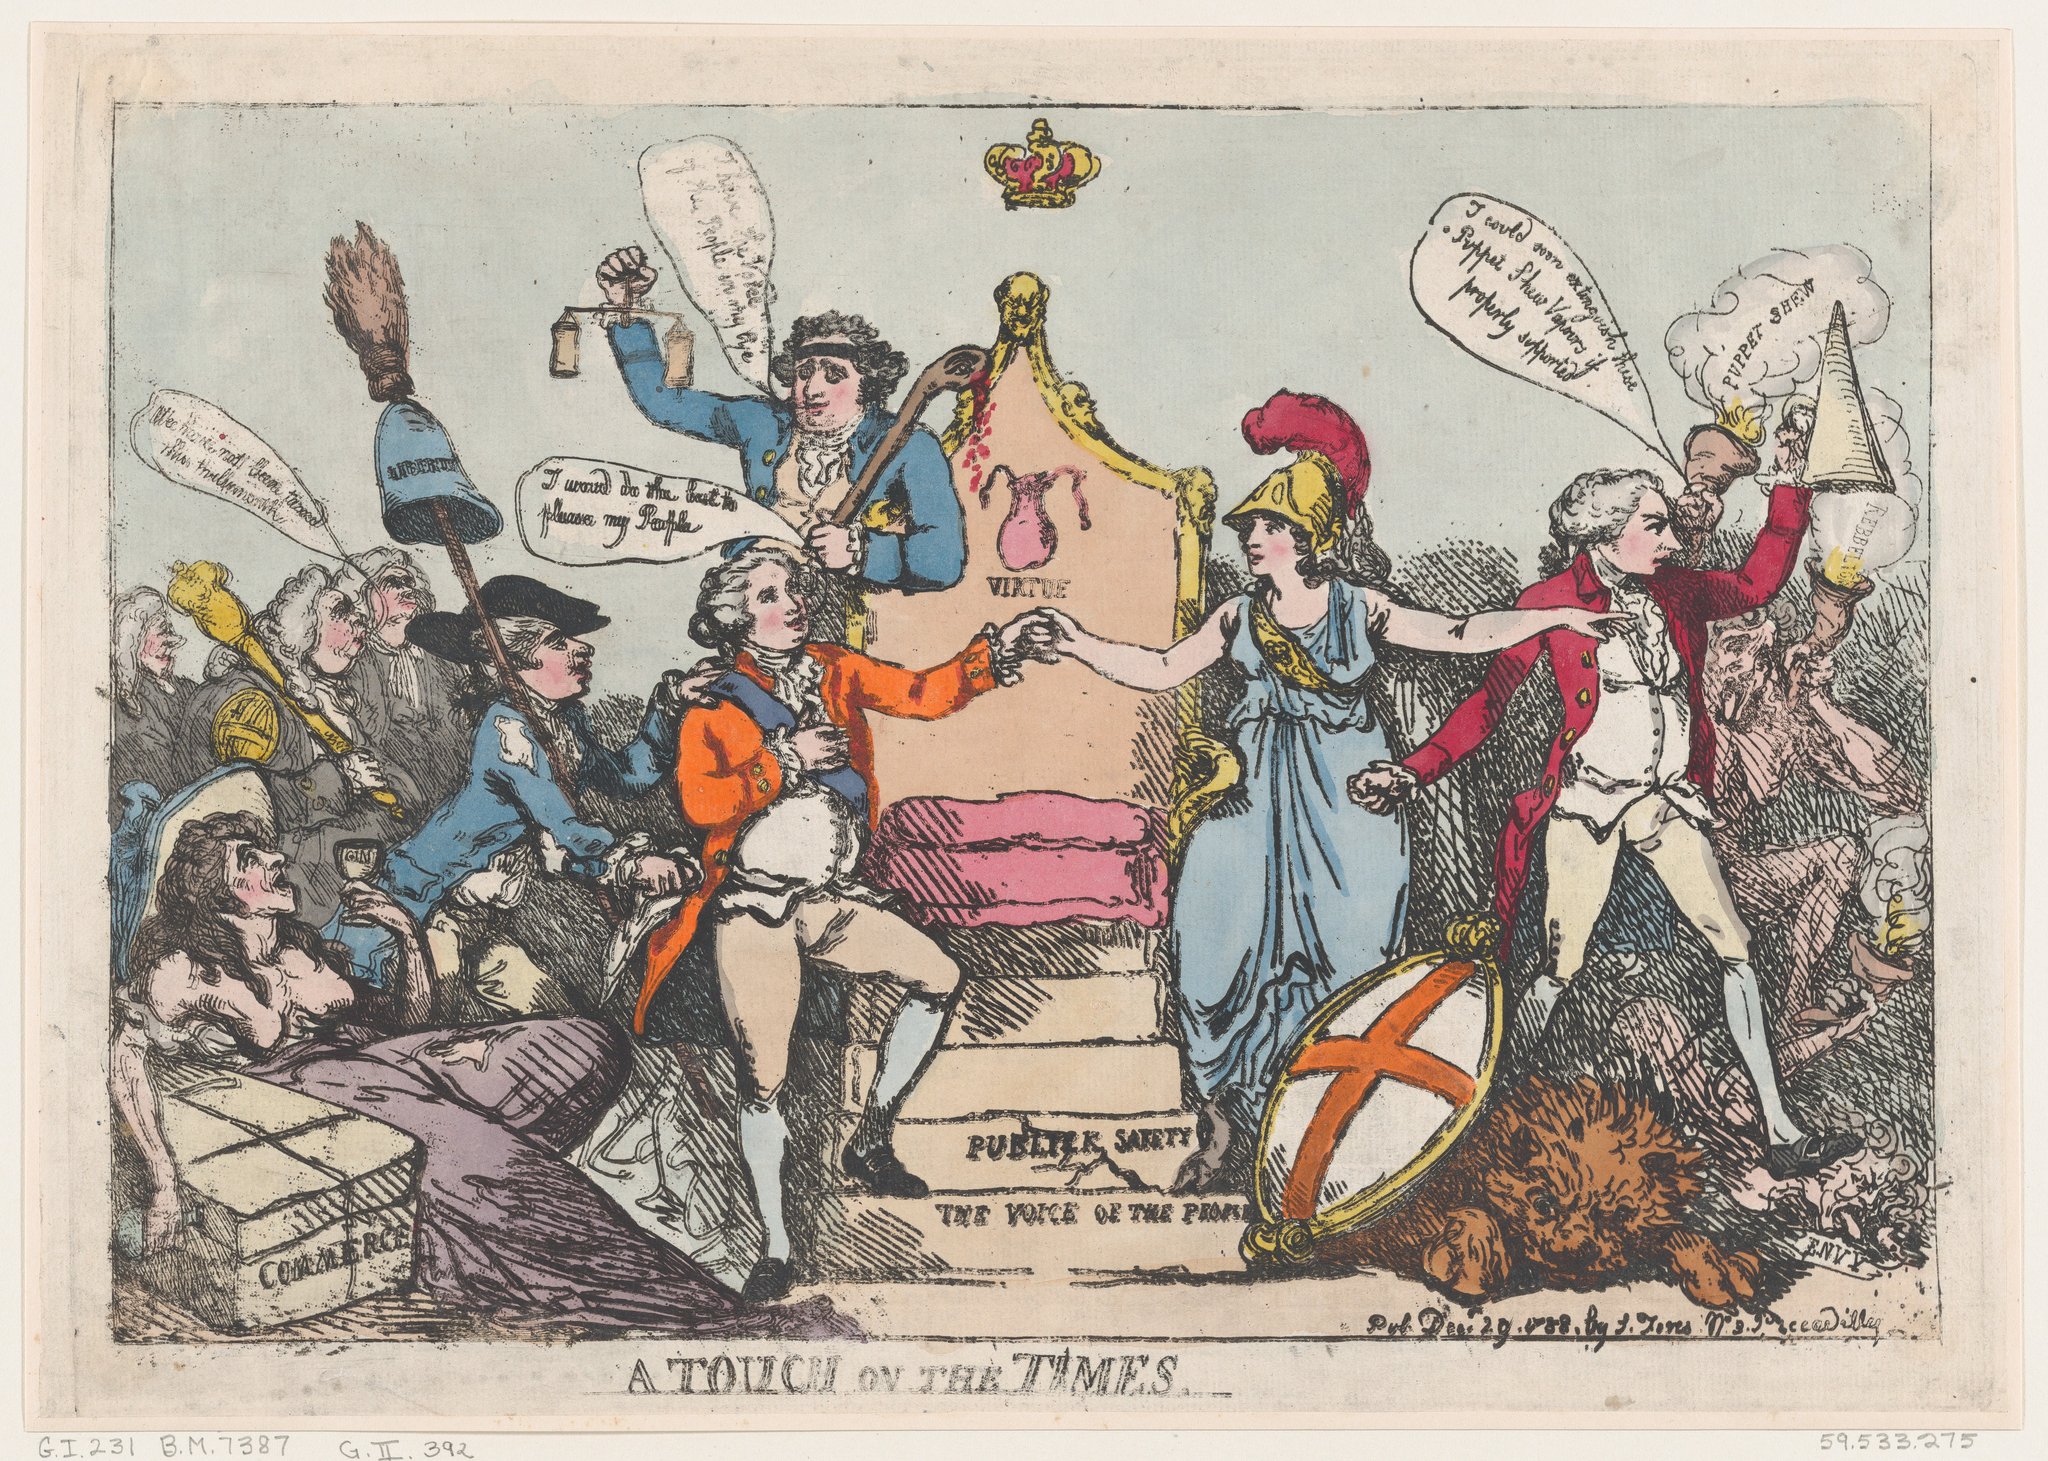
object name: print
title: A Touch on the Times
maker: thomas rowlandson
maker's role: artist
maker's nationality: british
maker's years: 1757-1827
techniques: etching, printing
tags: satire,men,women,politics